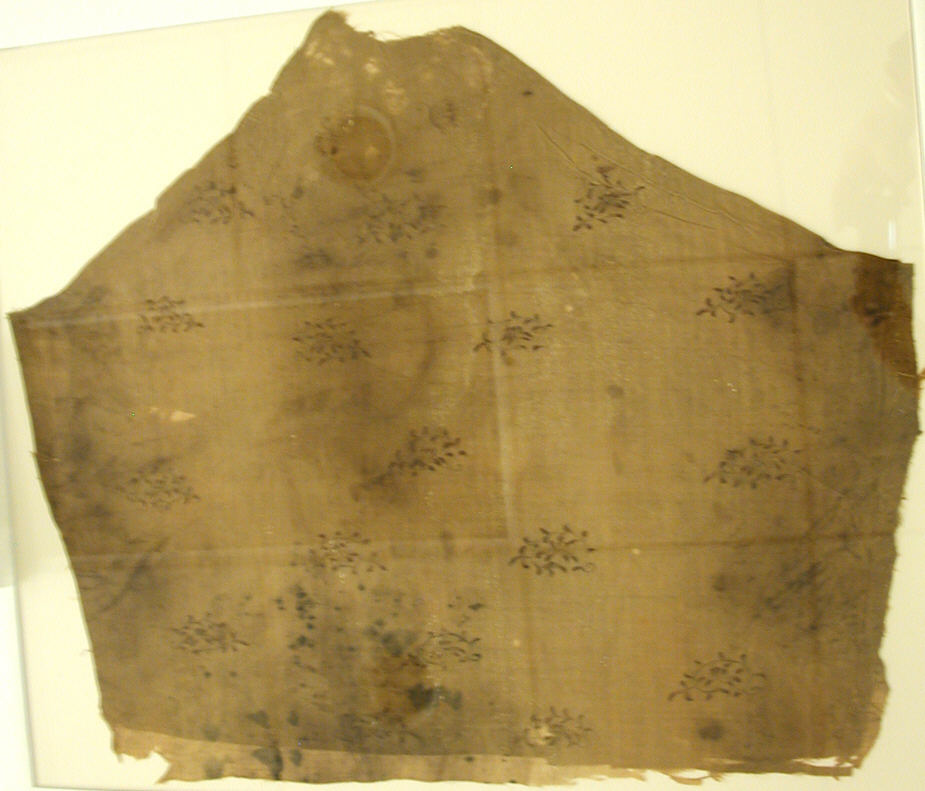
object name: painted textile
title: Painted textile with scattered floral scrolls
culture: chinese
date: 907-1125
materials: ink, pigment, silk